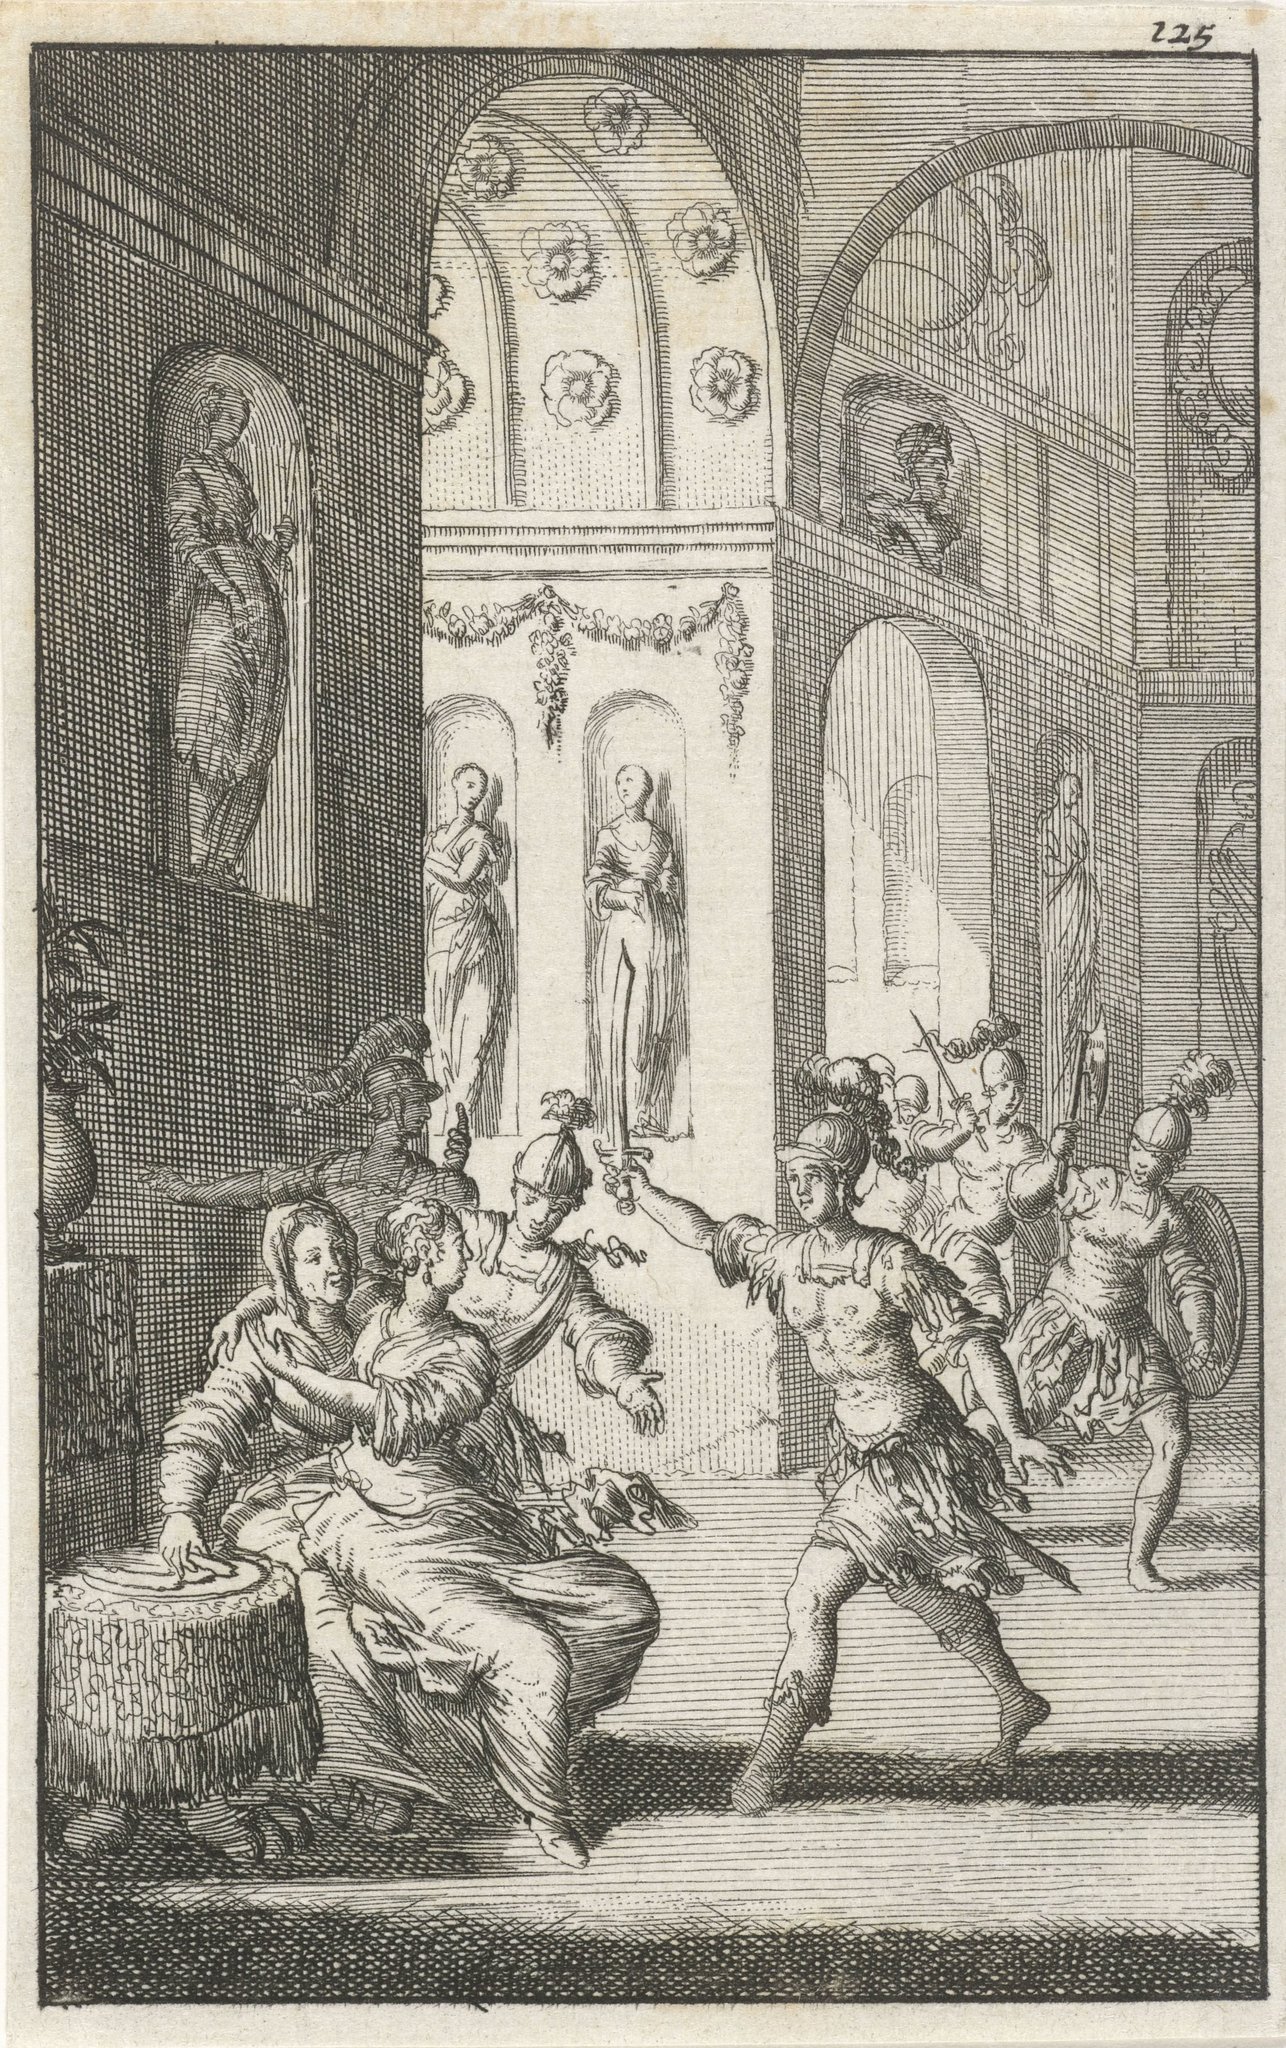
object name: print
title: Gewapende mannen ontvoeren een Romeinse bruid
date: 1681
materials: paper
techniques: etching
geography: amsterdam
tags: wife-capture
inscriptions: collector's mark: Lugt 2228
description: Illustratie opgenomen in: Neyn, Pieter de. Lust-hof der huwelyken, behelsende verscheyde seldsame ceremonien (...) by verscheyde natien. Amsterdam: Jan Bouman, 1681.